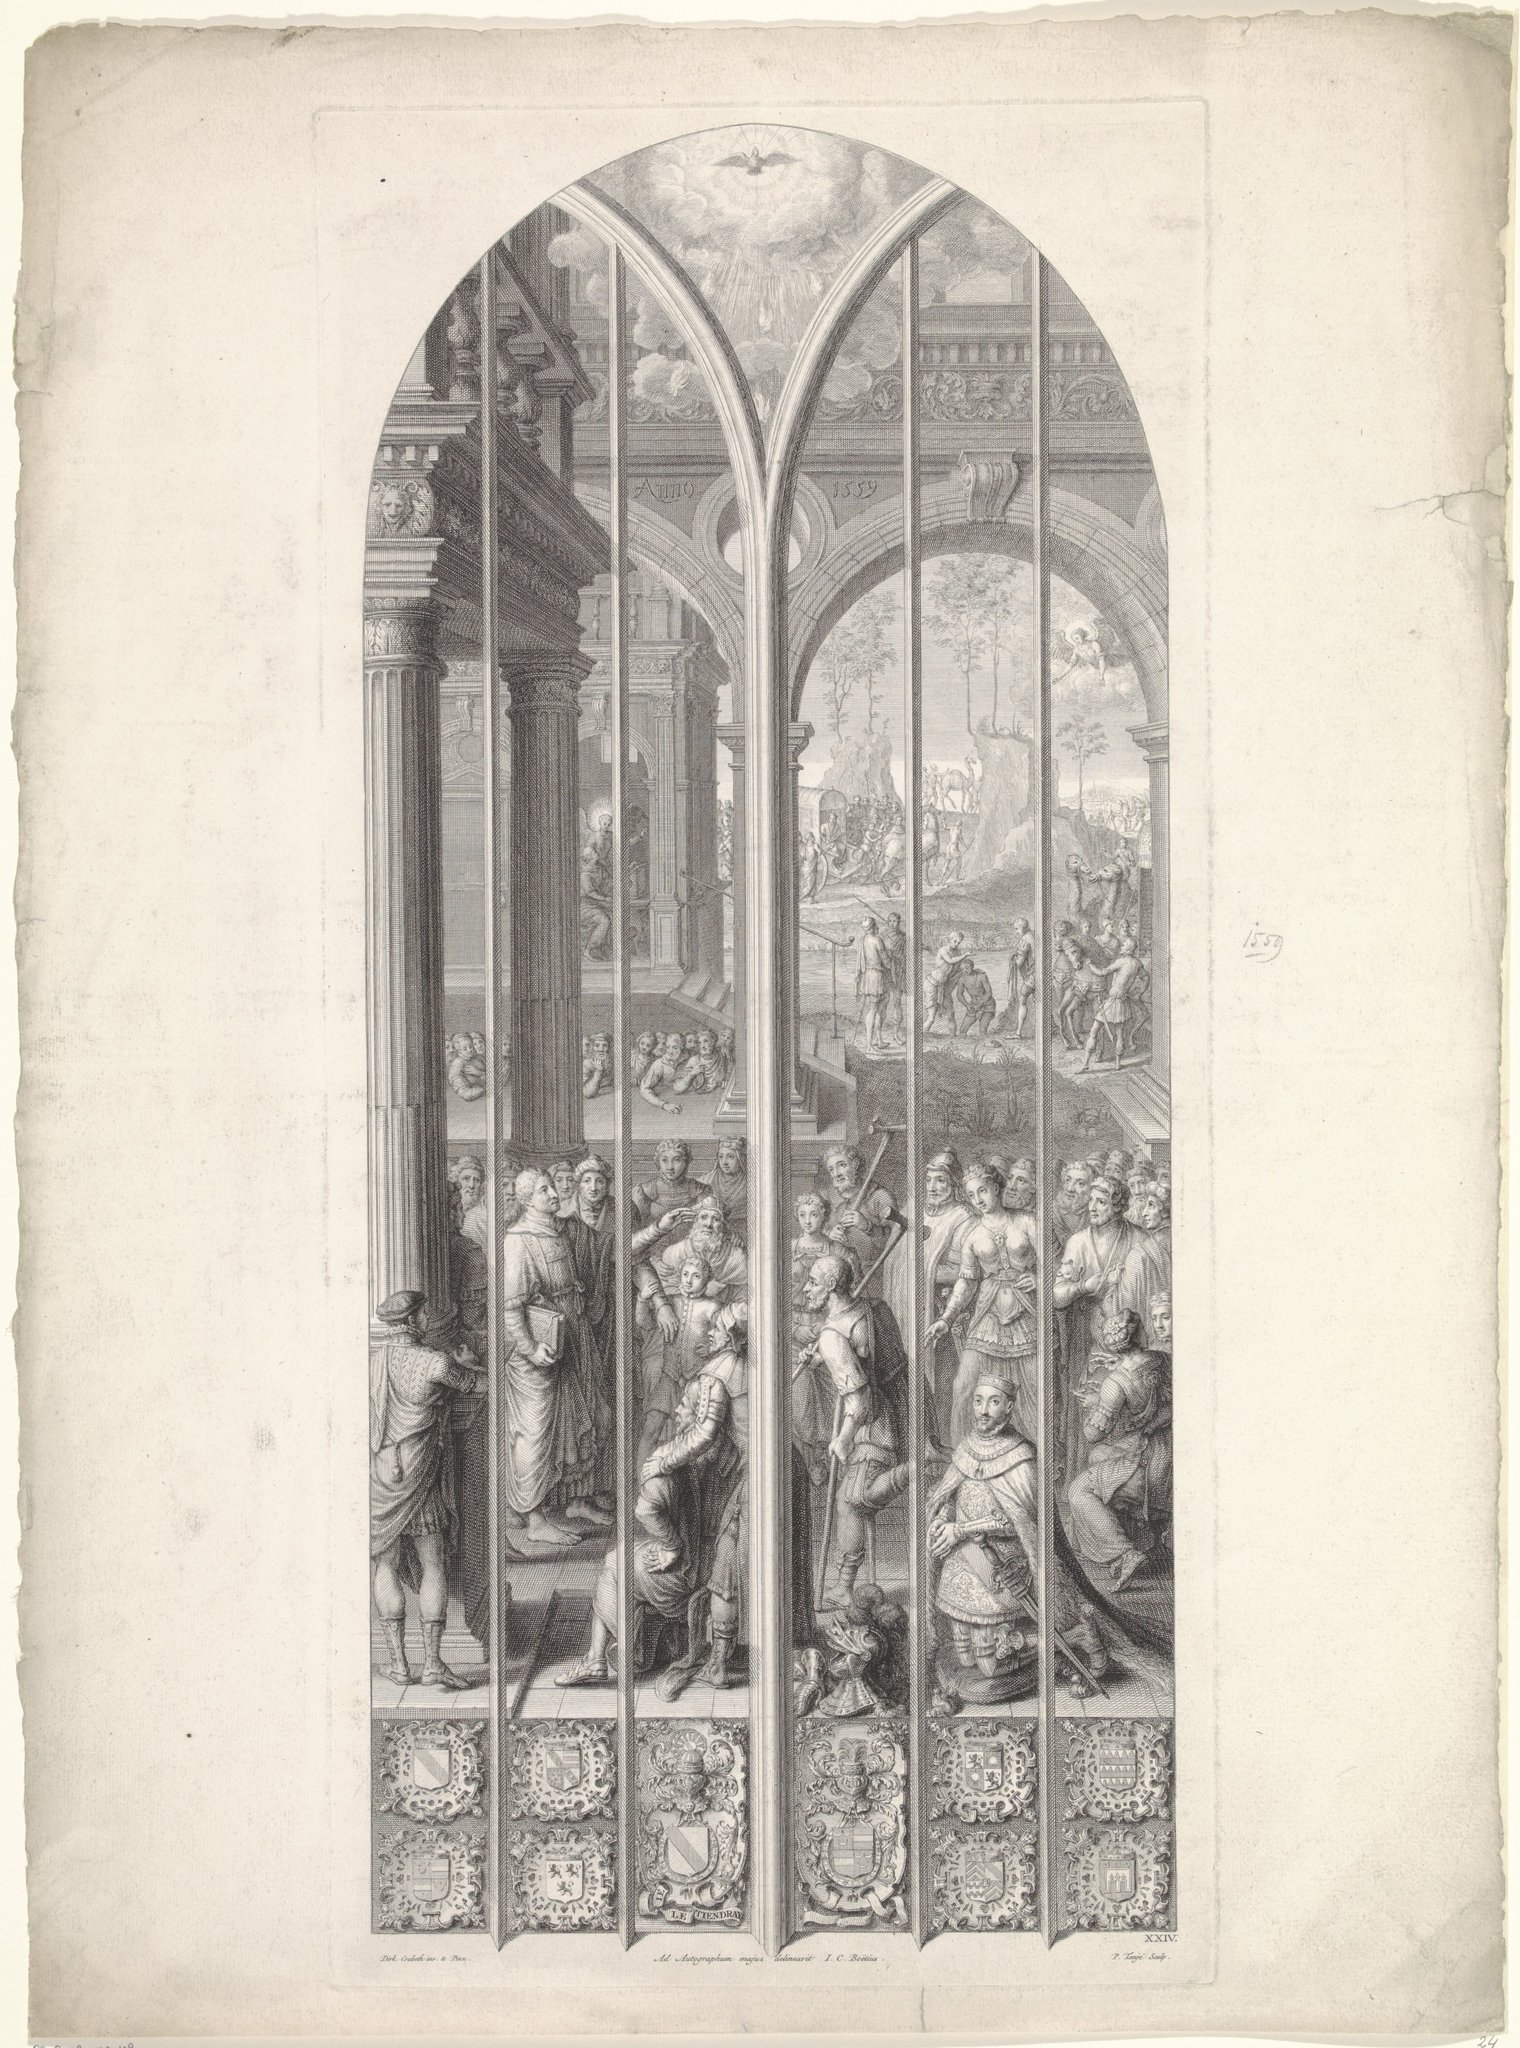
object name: print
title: Glasraam 24 in de Sint-Janskerk te Gouda: Filippus predikend, genezend en dopend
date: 1738-1754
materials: paper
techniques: engraving, etching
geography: amsterdam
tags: philip baptizes the eunuch, church-window, e.g. rose-window, disabilities, deformations, philip preaching (in samaria) (acts 8:4-25)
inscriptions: collector's mark: Lugt 2228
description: Het vierentwintigste glasraam in de Sint-Janskerk te Gouda met de voorstelling van Filippus, die met een boek onder de arm predikt voor een menigte. Kreupelen komen naar hem toe voor genezing. Op de achtergrond in een vertrek krijgt Filippus van een engel de opdracht om naar de weg te gaan. Vervolgens komt Filippus de eunuch in zijn reiswagen tegen, de Ethiopische ambtenaar, die hij helpt bij het lezen van een Bijbeltekst. In het midden doopt Filippus de Ethiopiër. Rechts op de voorgrond graaf Filips van Ligne, heer van Wassenaar, de schenker van het glasraam.